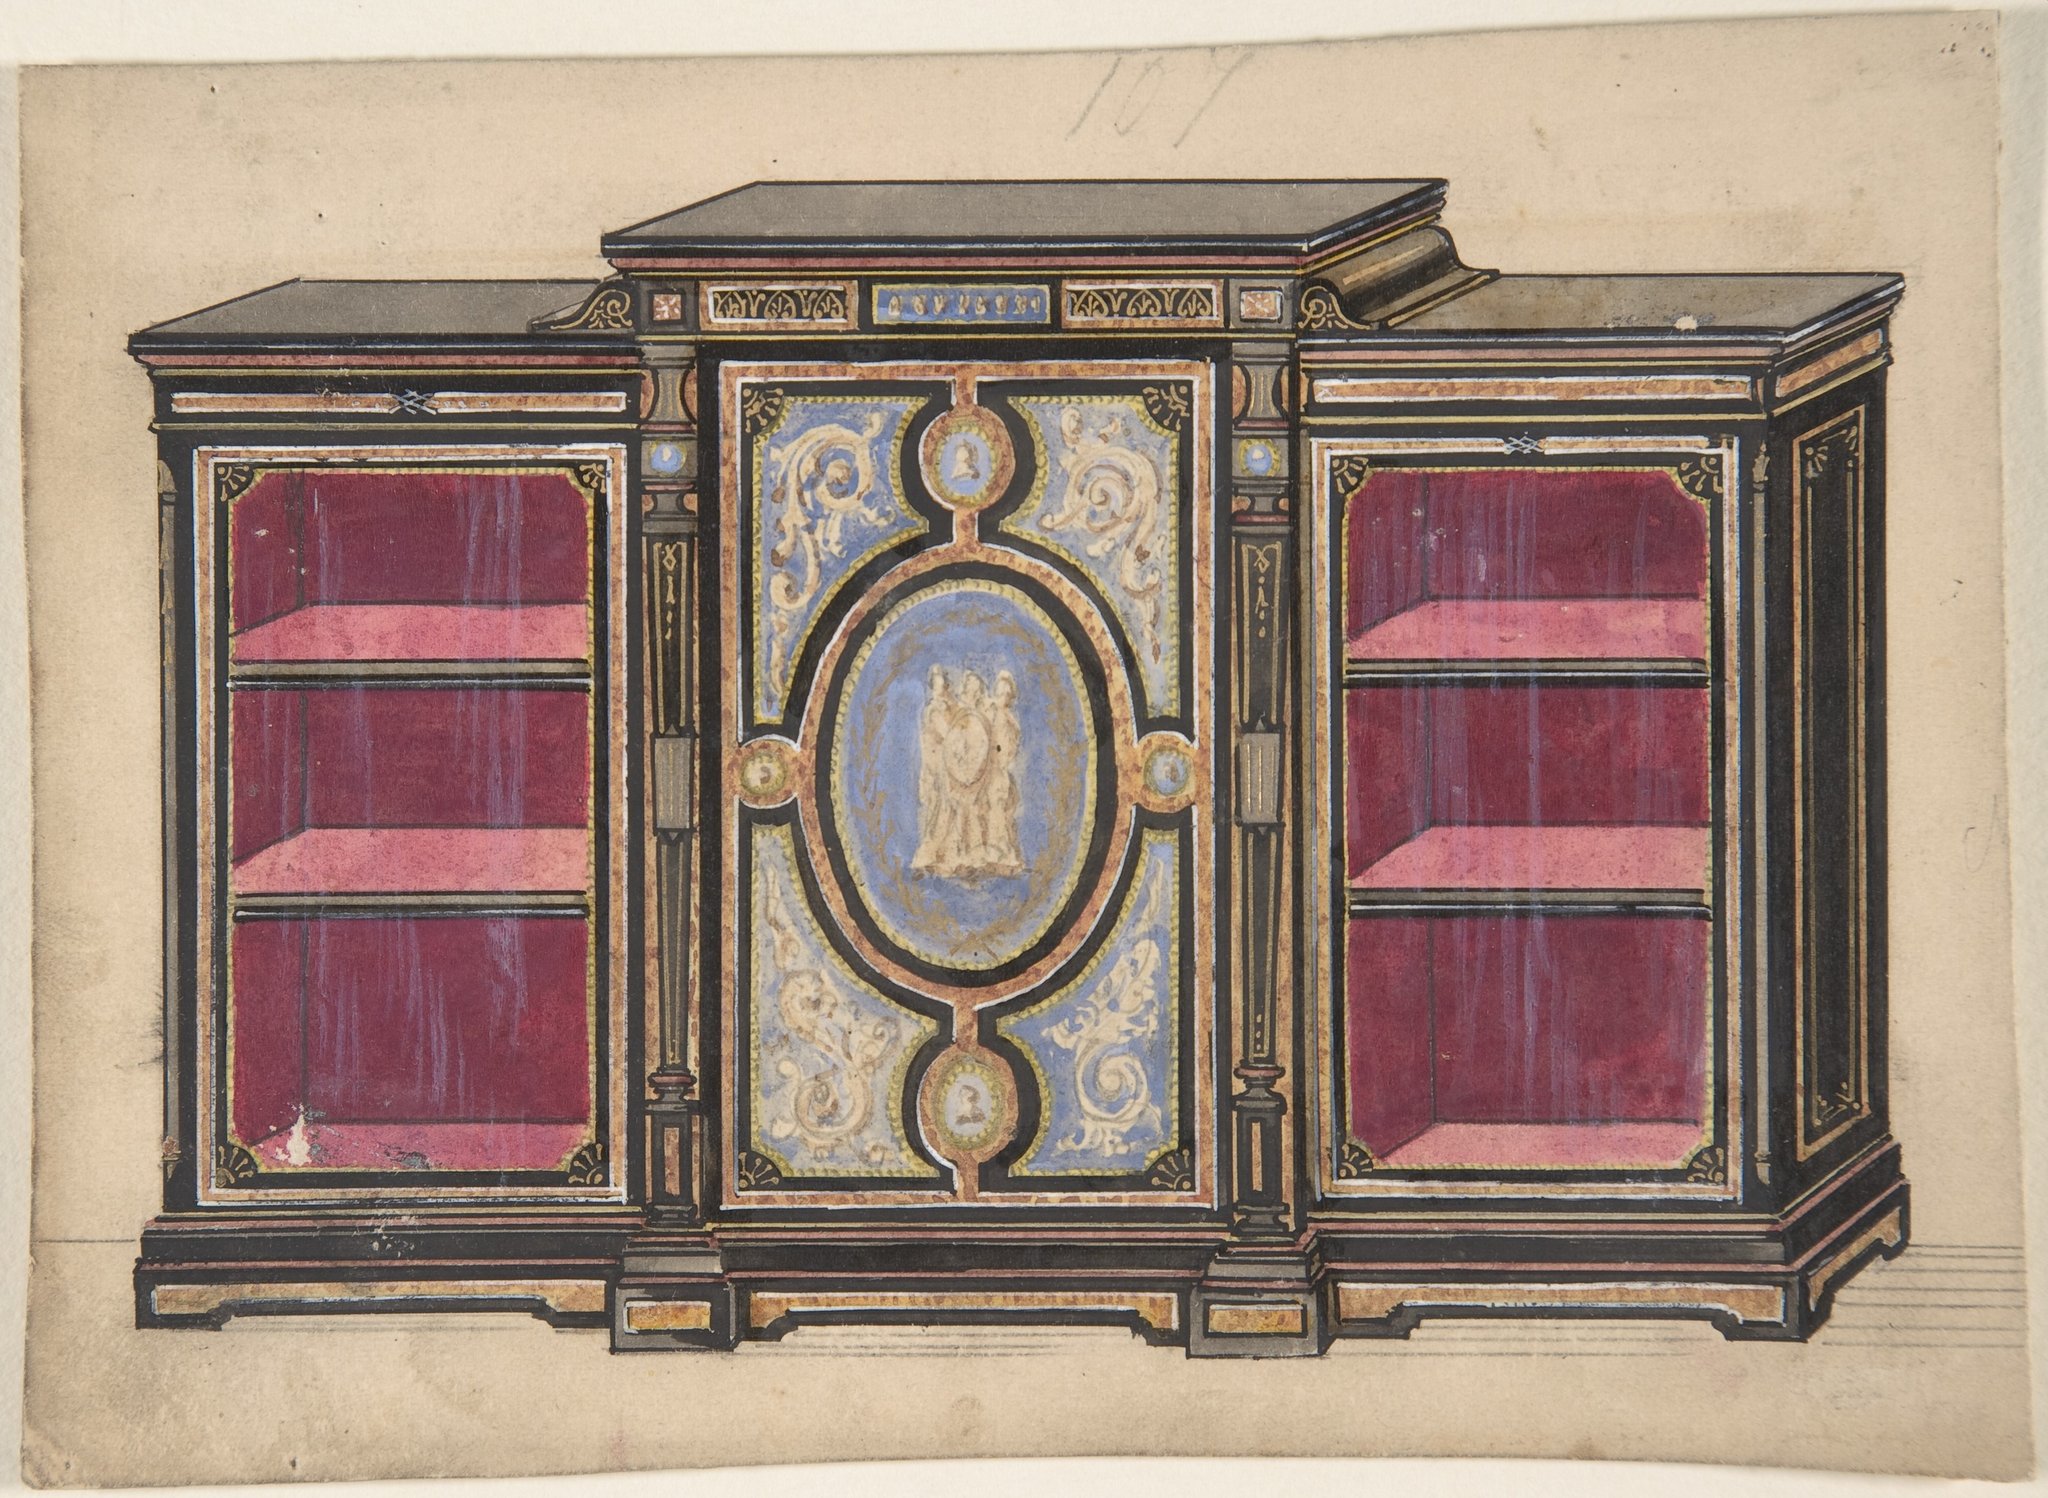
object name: drawing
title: Cabinet Design with Renaissance style Ornament and Red Interior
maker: anonymous, british, 19th century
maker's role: artist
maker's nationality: british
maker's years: 1800-1900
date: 1801-1900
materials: ink, watercolor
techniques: pen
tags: cabinets